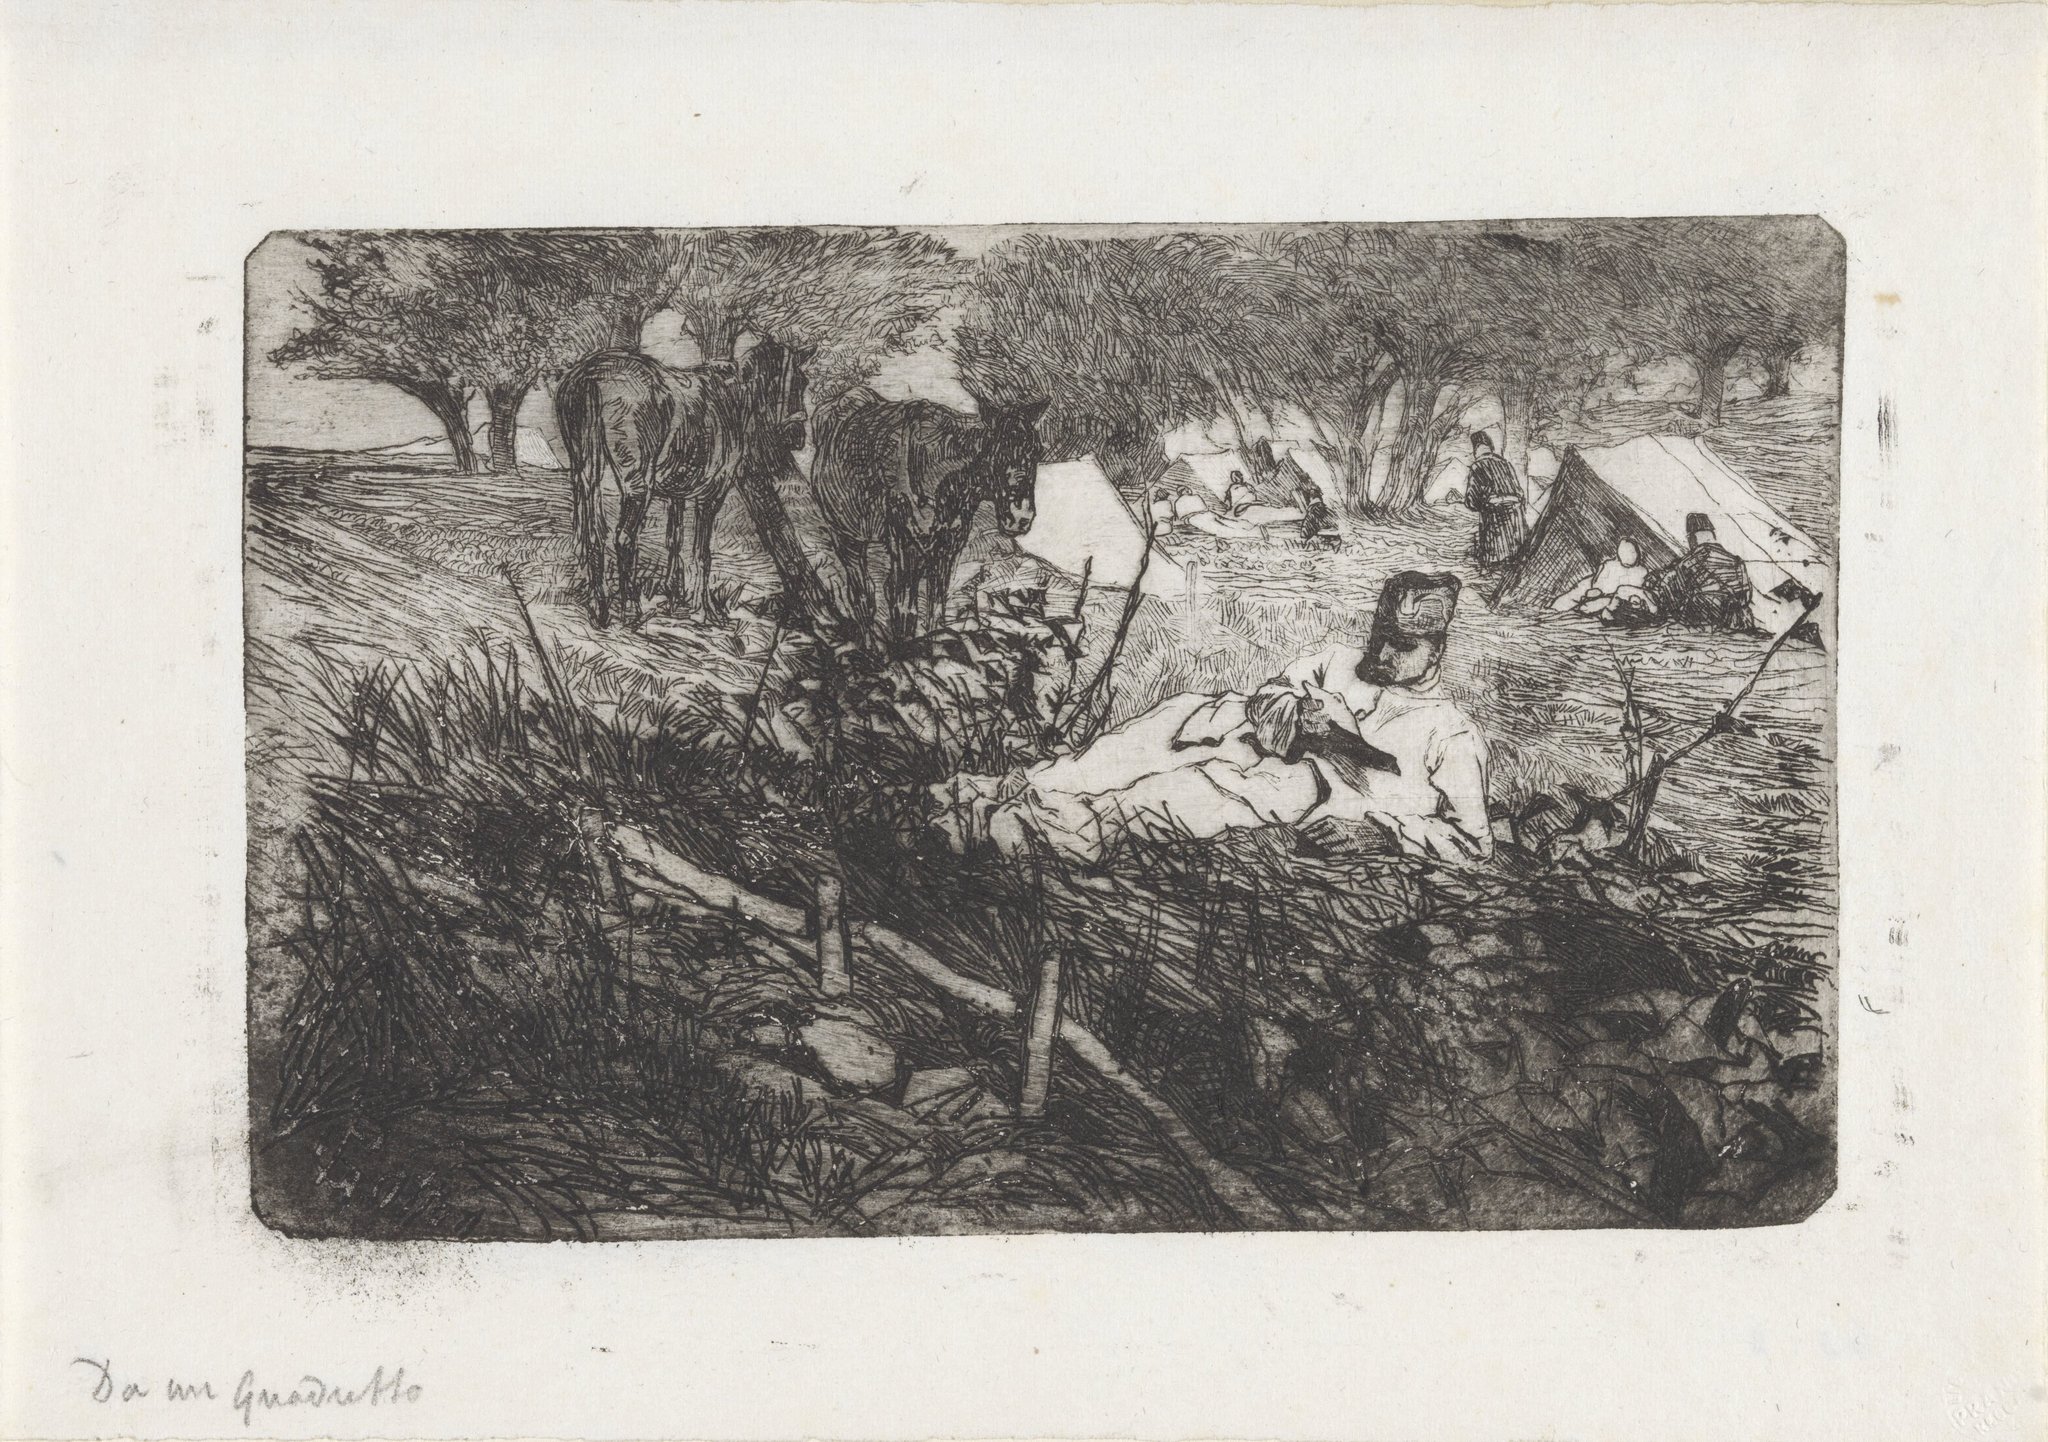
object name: print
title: La Lettera al Campo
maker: giovanni fattori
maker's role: print maker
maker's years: 1825-1908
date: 1835-1908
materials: paper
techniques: etching, intaglio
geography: italy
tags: leave ~ the soldier off duty, reading, the soldier; the soldier's life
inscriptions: collector's mark: Lugt 2228, collector's mark, collector's mark: Lugt 2760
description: Een soldaat ligt in het gras en leest een boek. Op de achtergrond twee ezels en soldaten bij hun tenten.